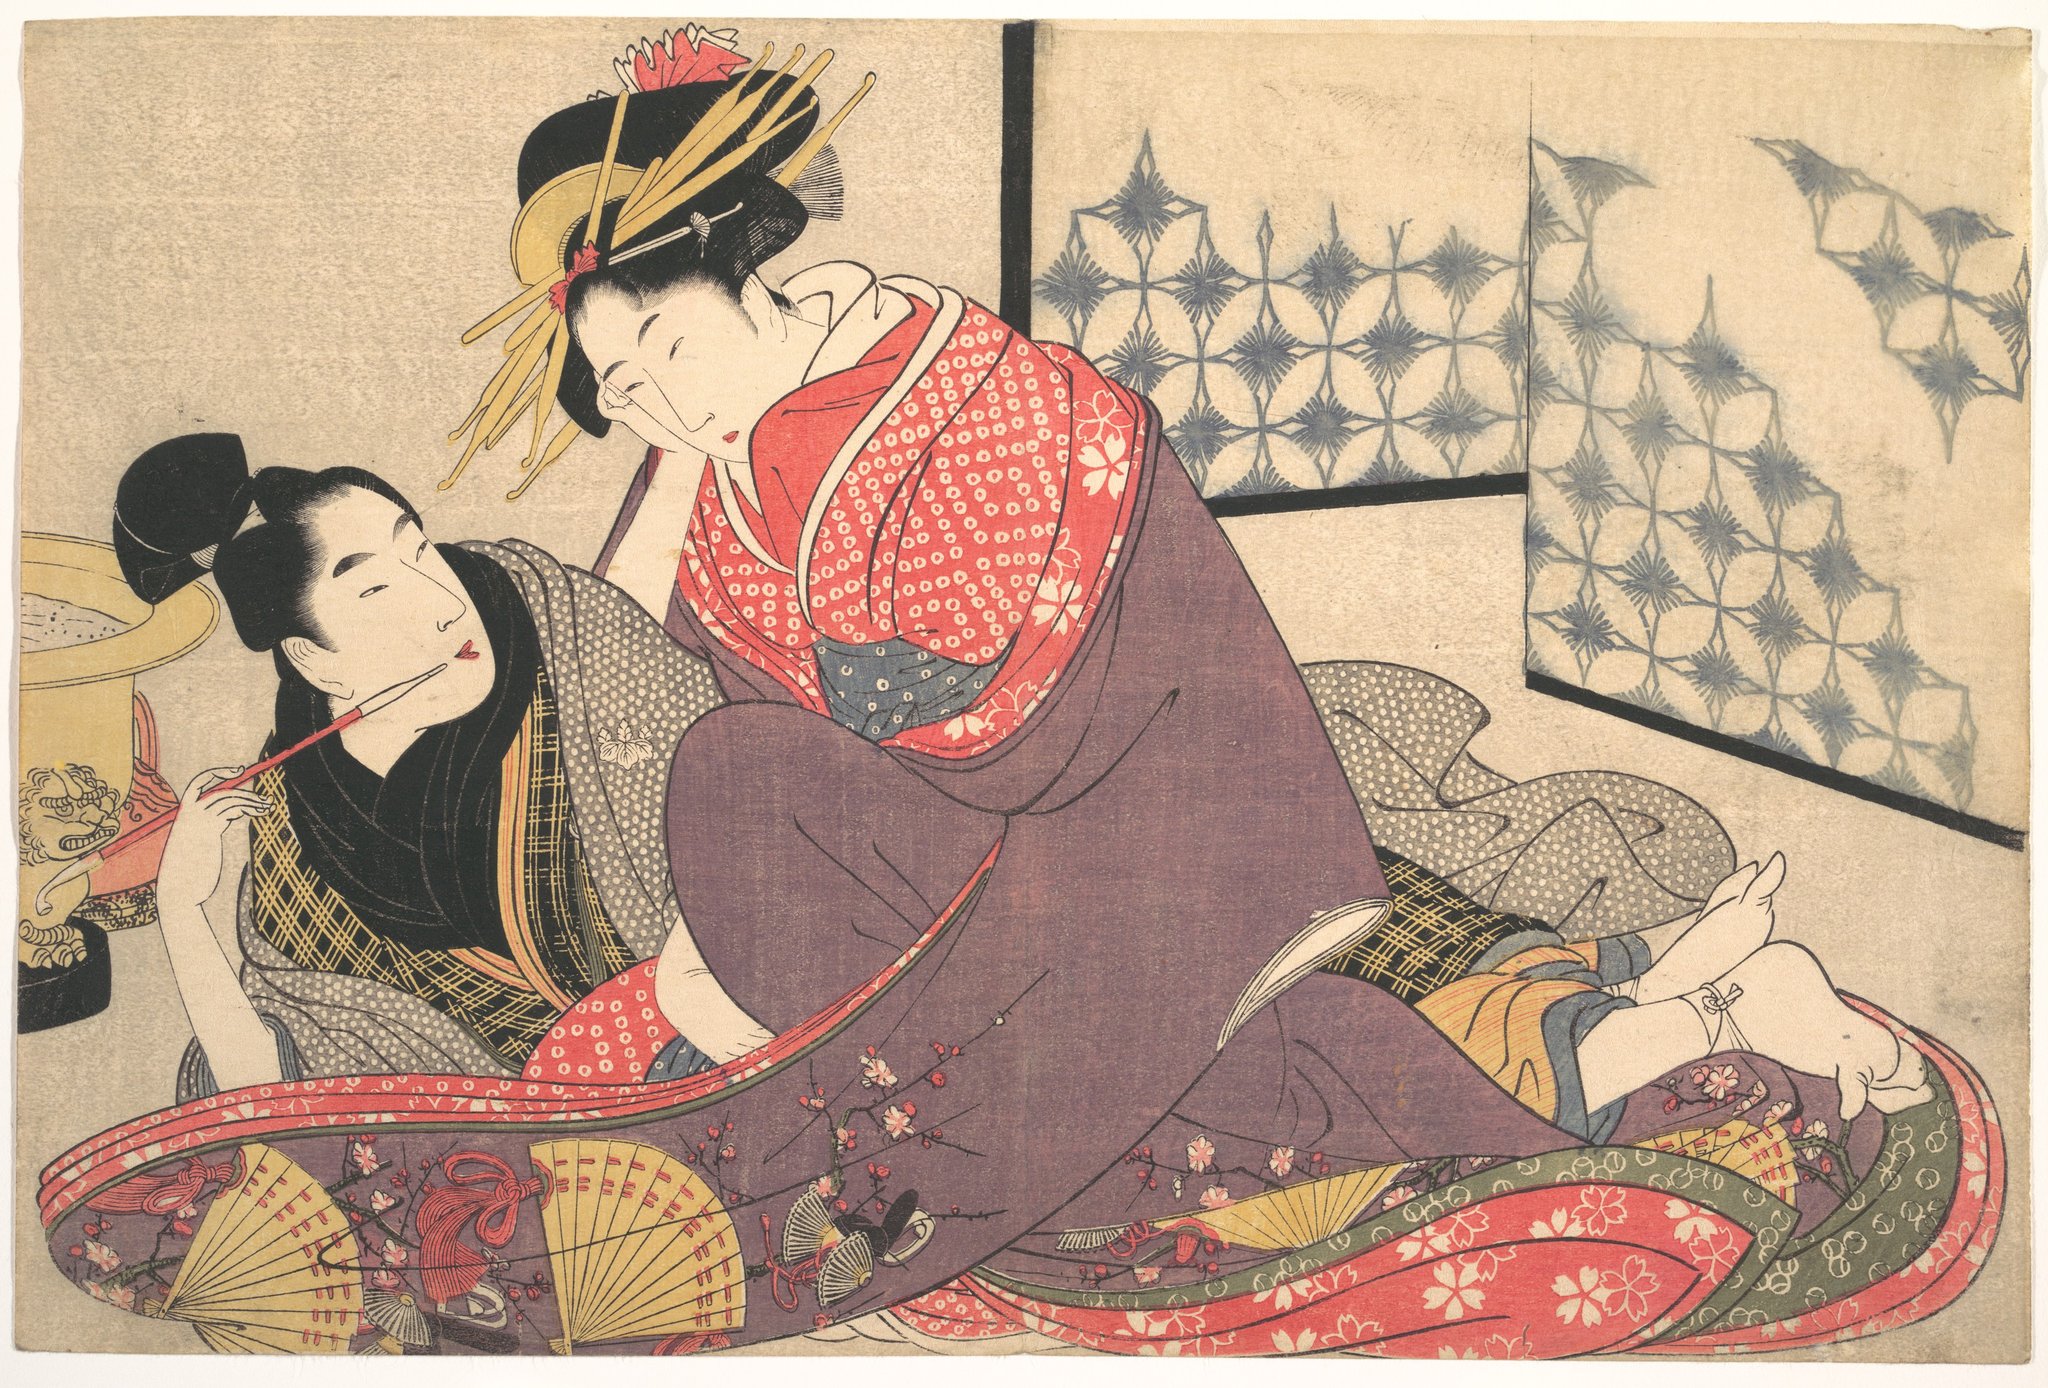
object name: print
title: Erotic Print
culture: japanese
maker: kitagawa utamaro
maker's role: artist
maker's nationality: japanese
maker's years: 1754-1806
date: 1753-1806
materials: ink, paper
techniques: woodblock print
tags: couples,men,women